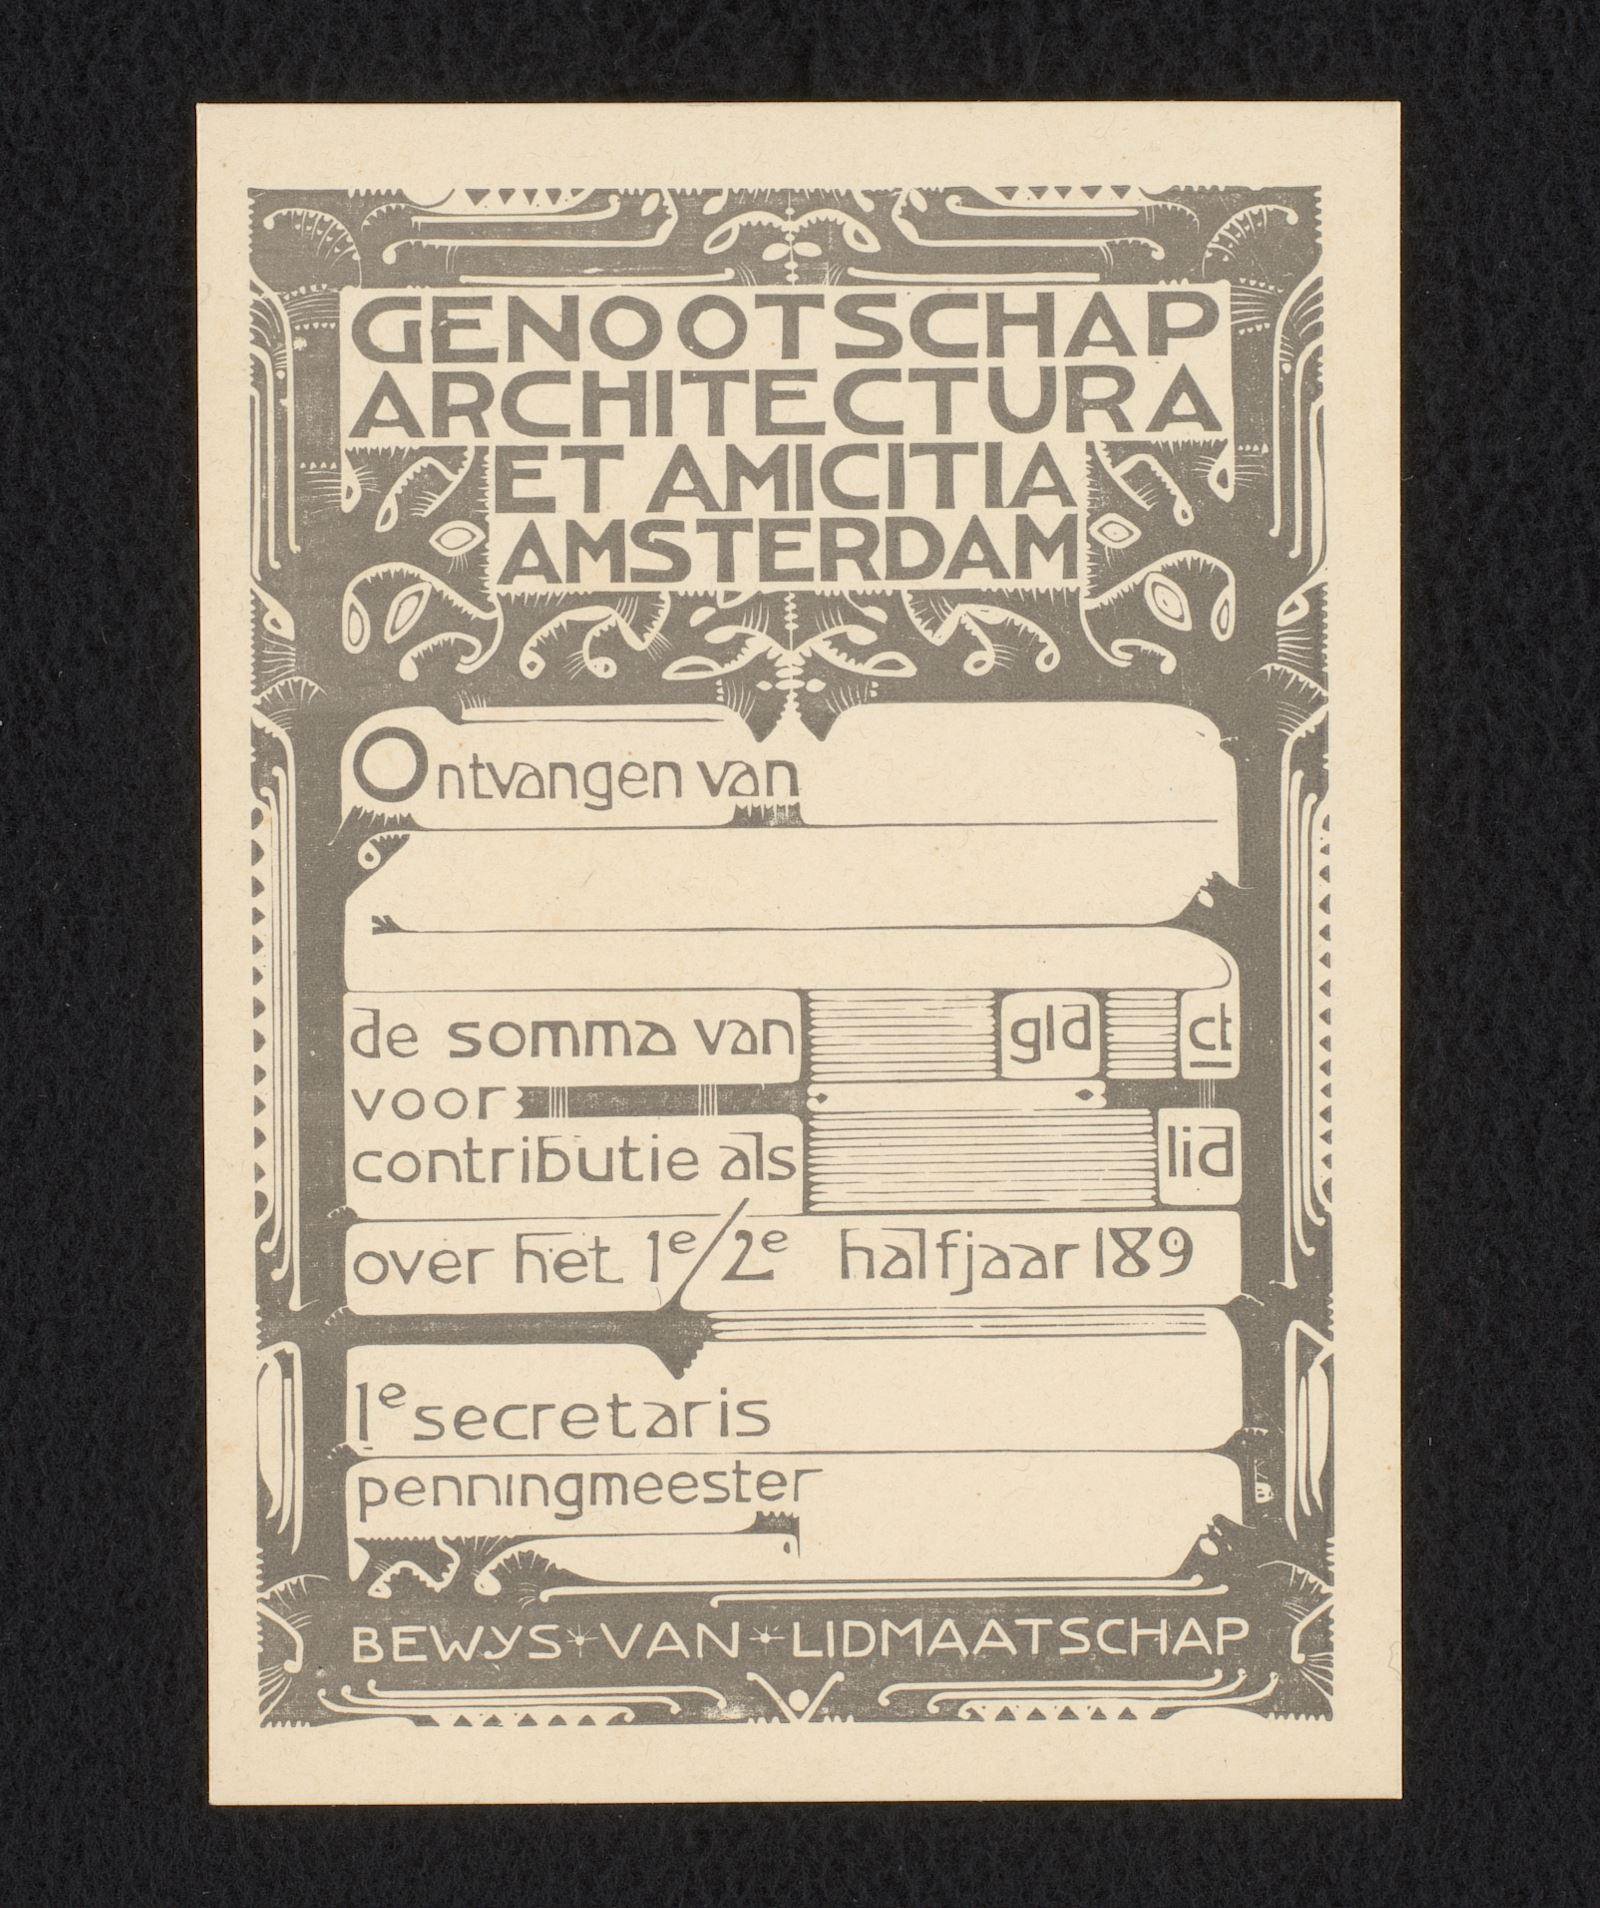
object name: print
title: Kwitantie van Architectura et Amicitia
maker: karel petrus cornelis de bazel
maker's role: draughtsman, print maker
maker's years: 1869-1923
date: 1897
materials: paper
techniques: woodcut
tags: cheque, draft, bill of exchange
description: Een kwitantie van het genootschap Architectura et Amicitia in Amsterdam, die tevens diende als bewijs van lidmaatschap. Op het verso de adresruimte van een briefkaart.